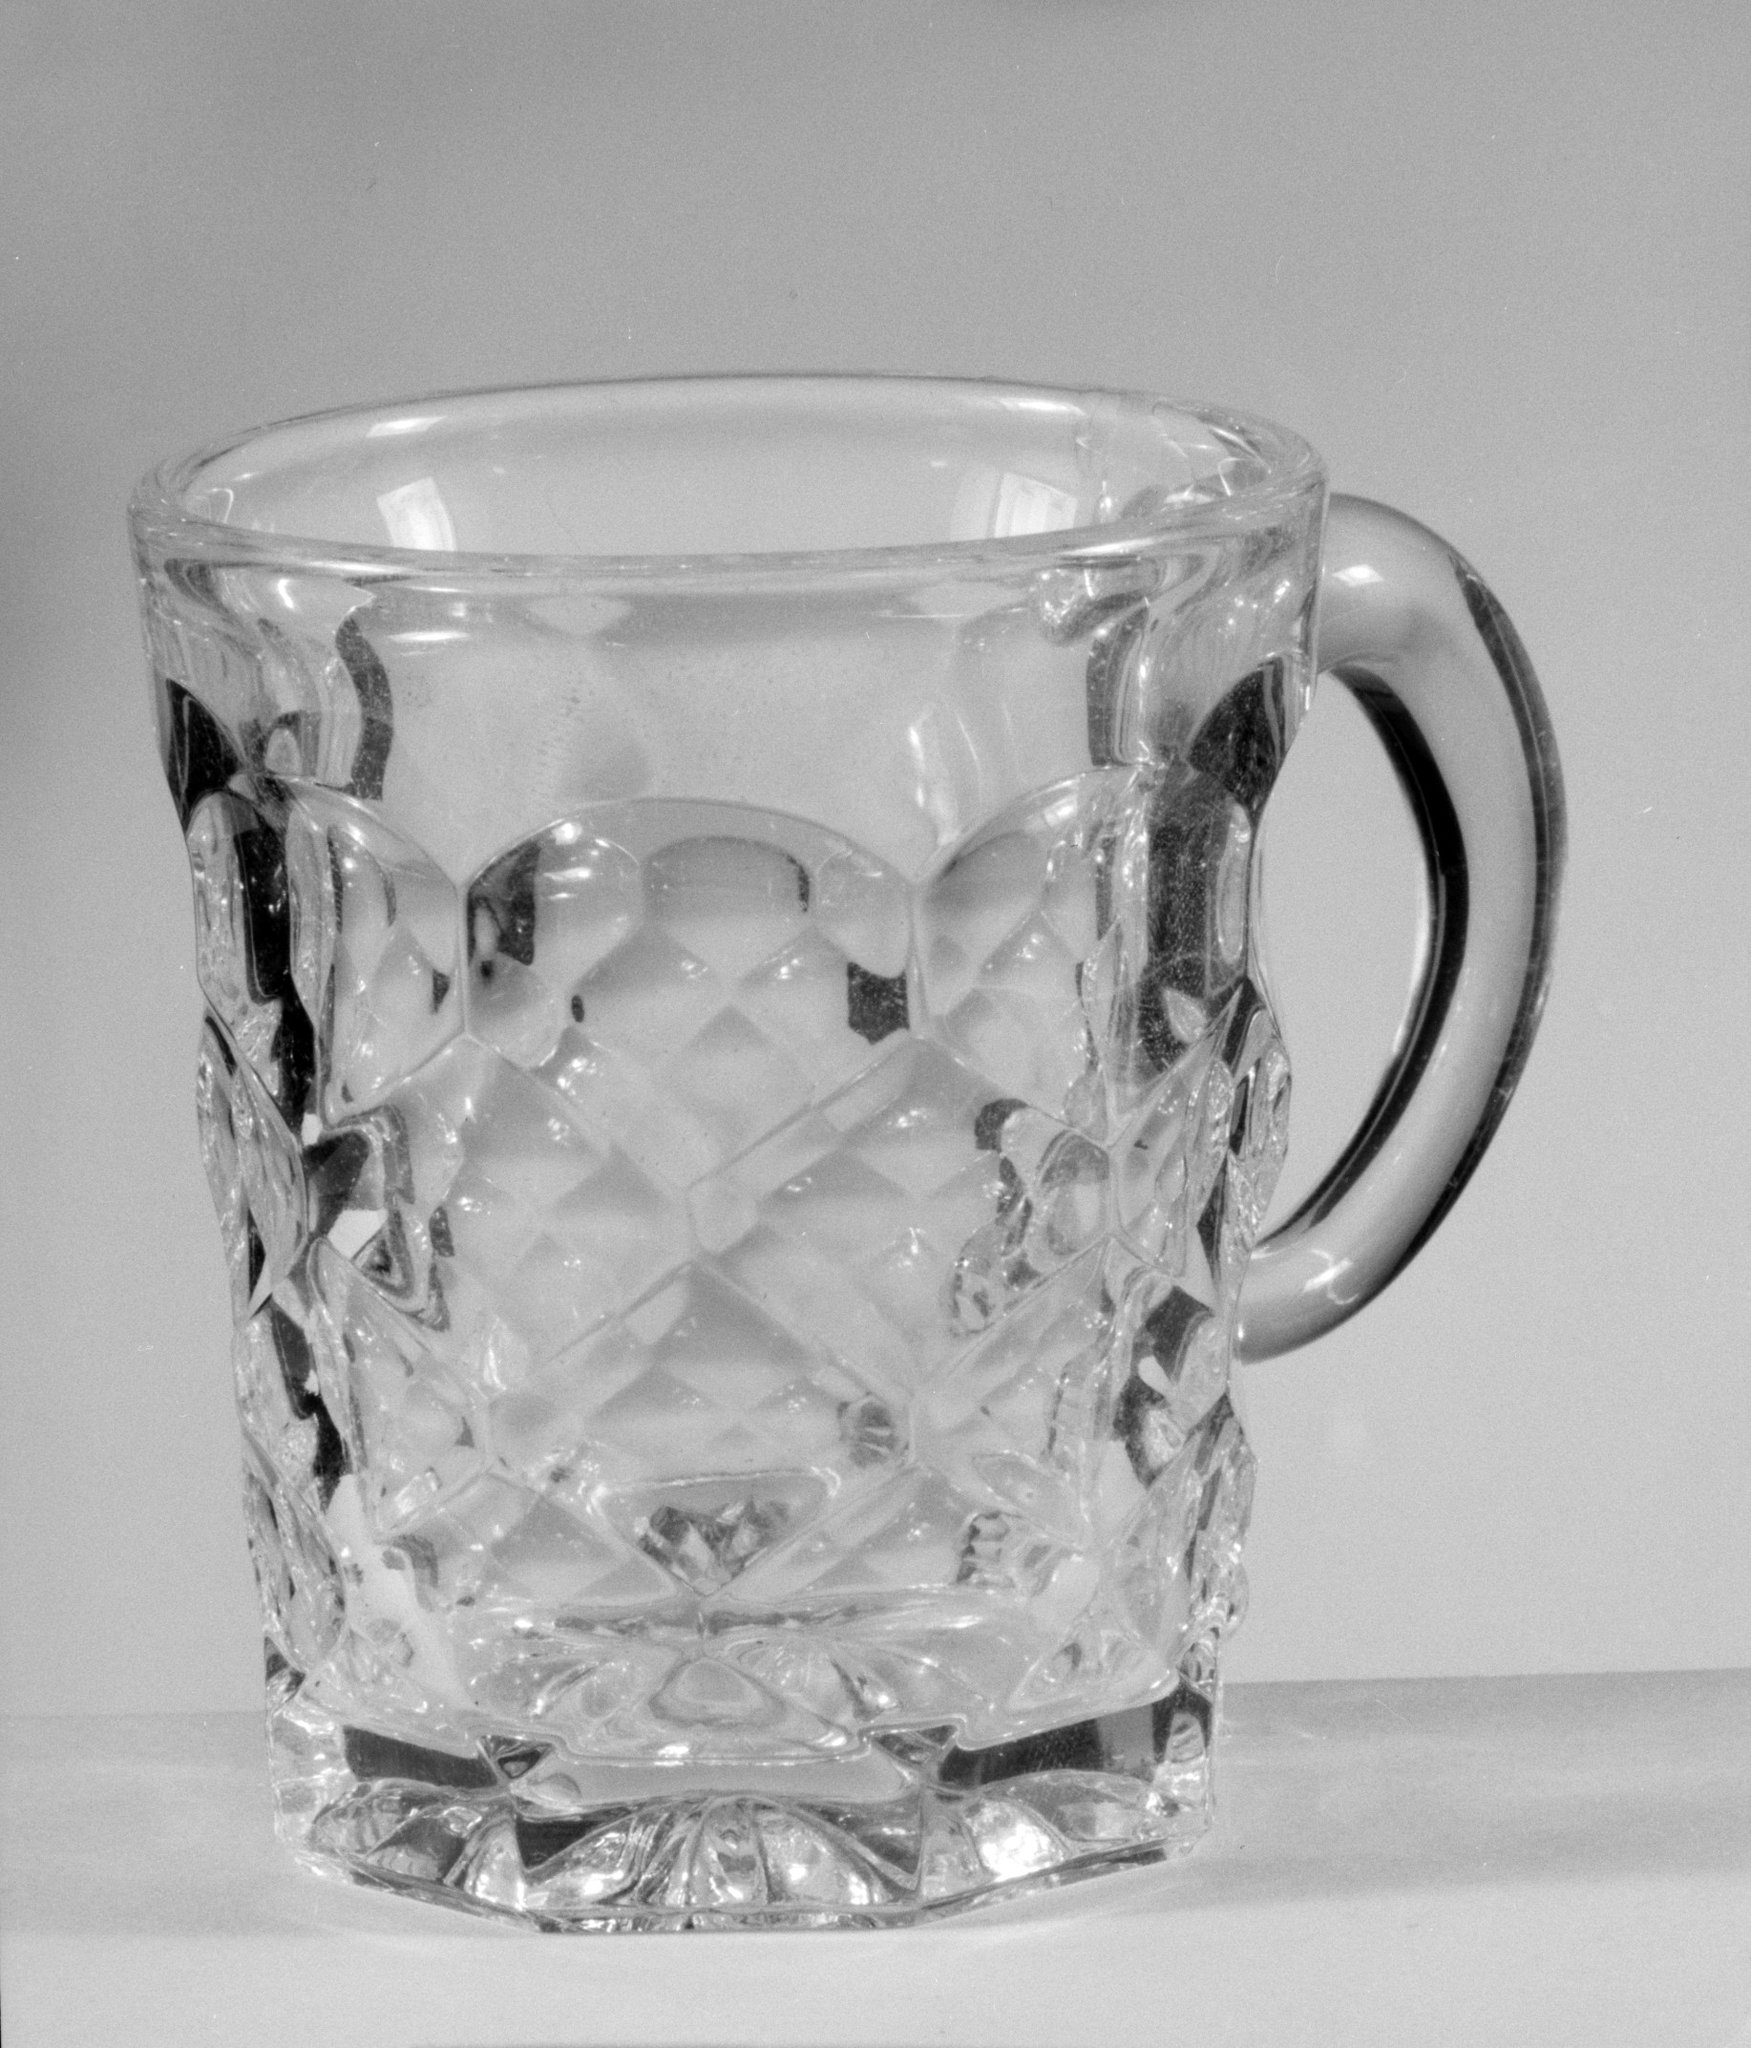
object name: mug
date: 1850-1870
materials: glass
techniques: pressed